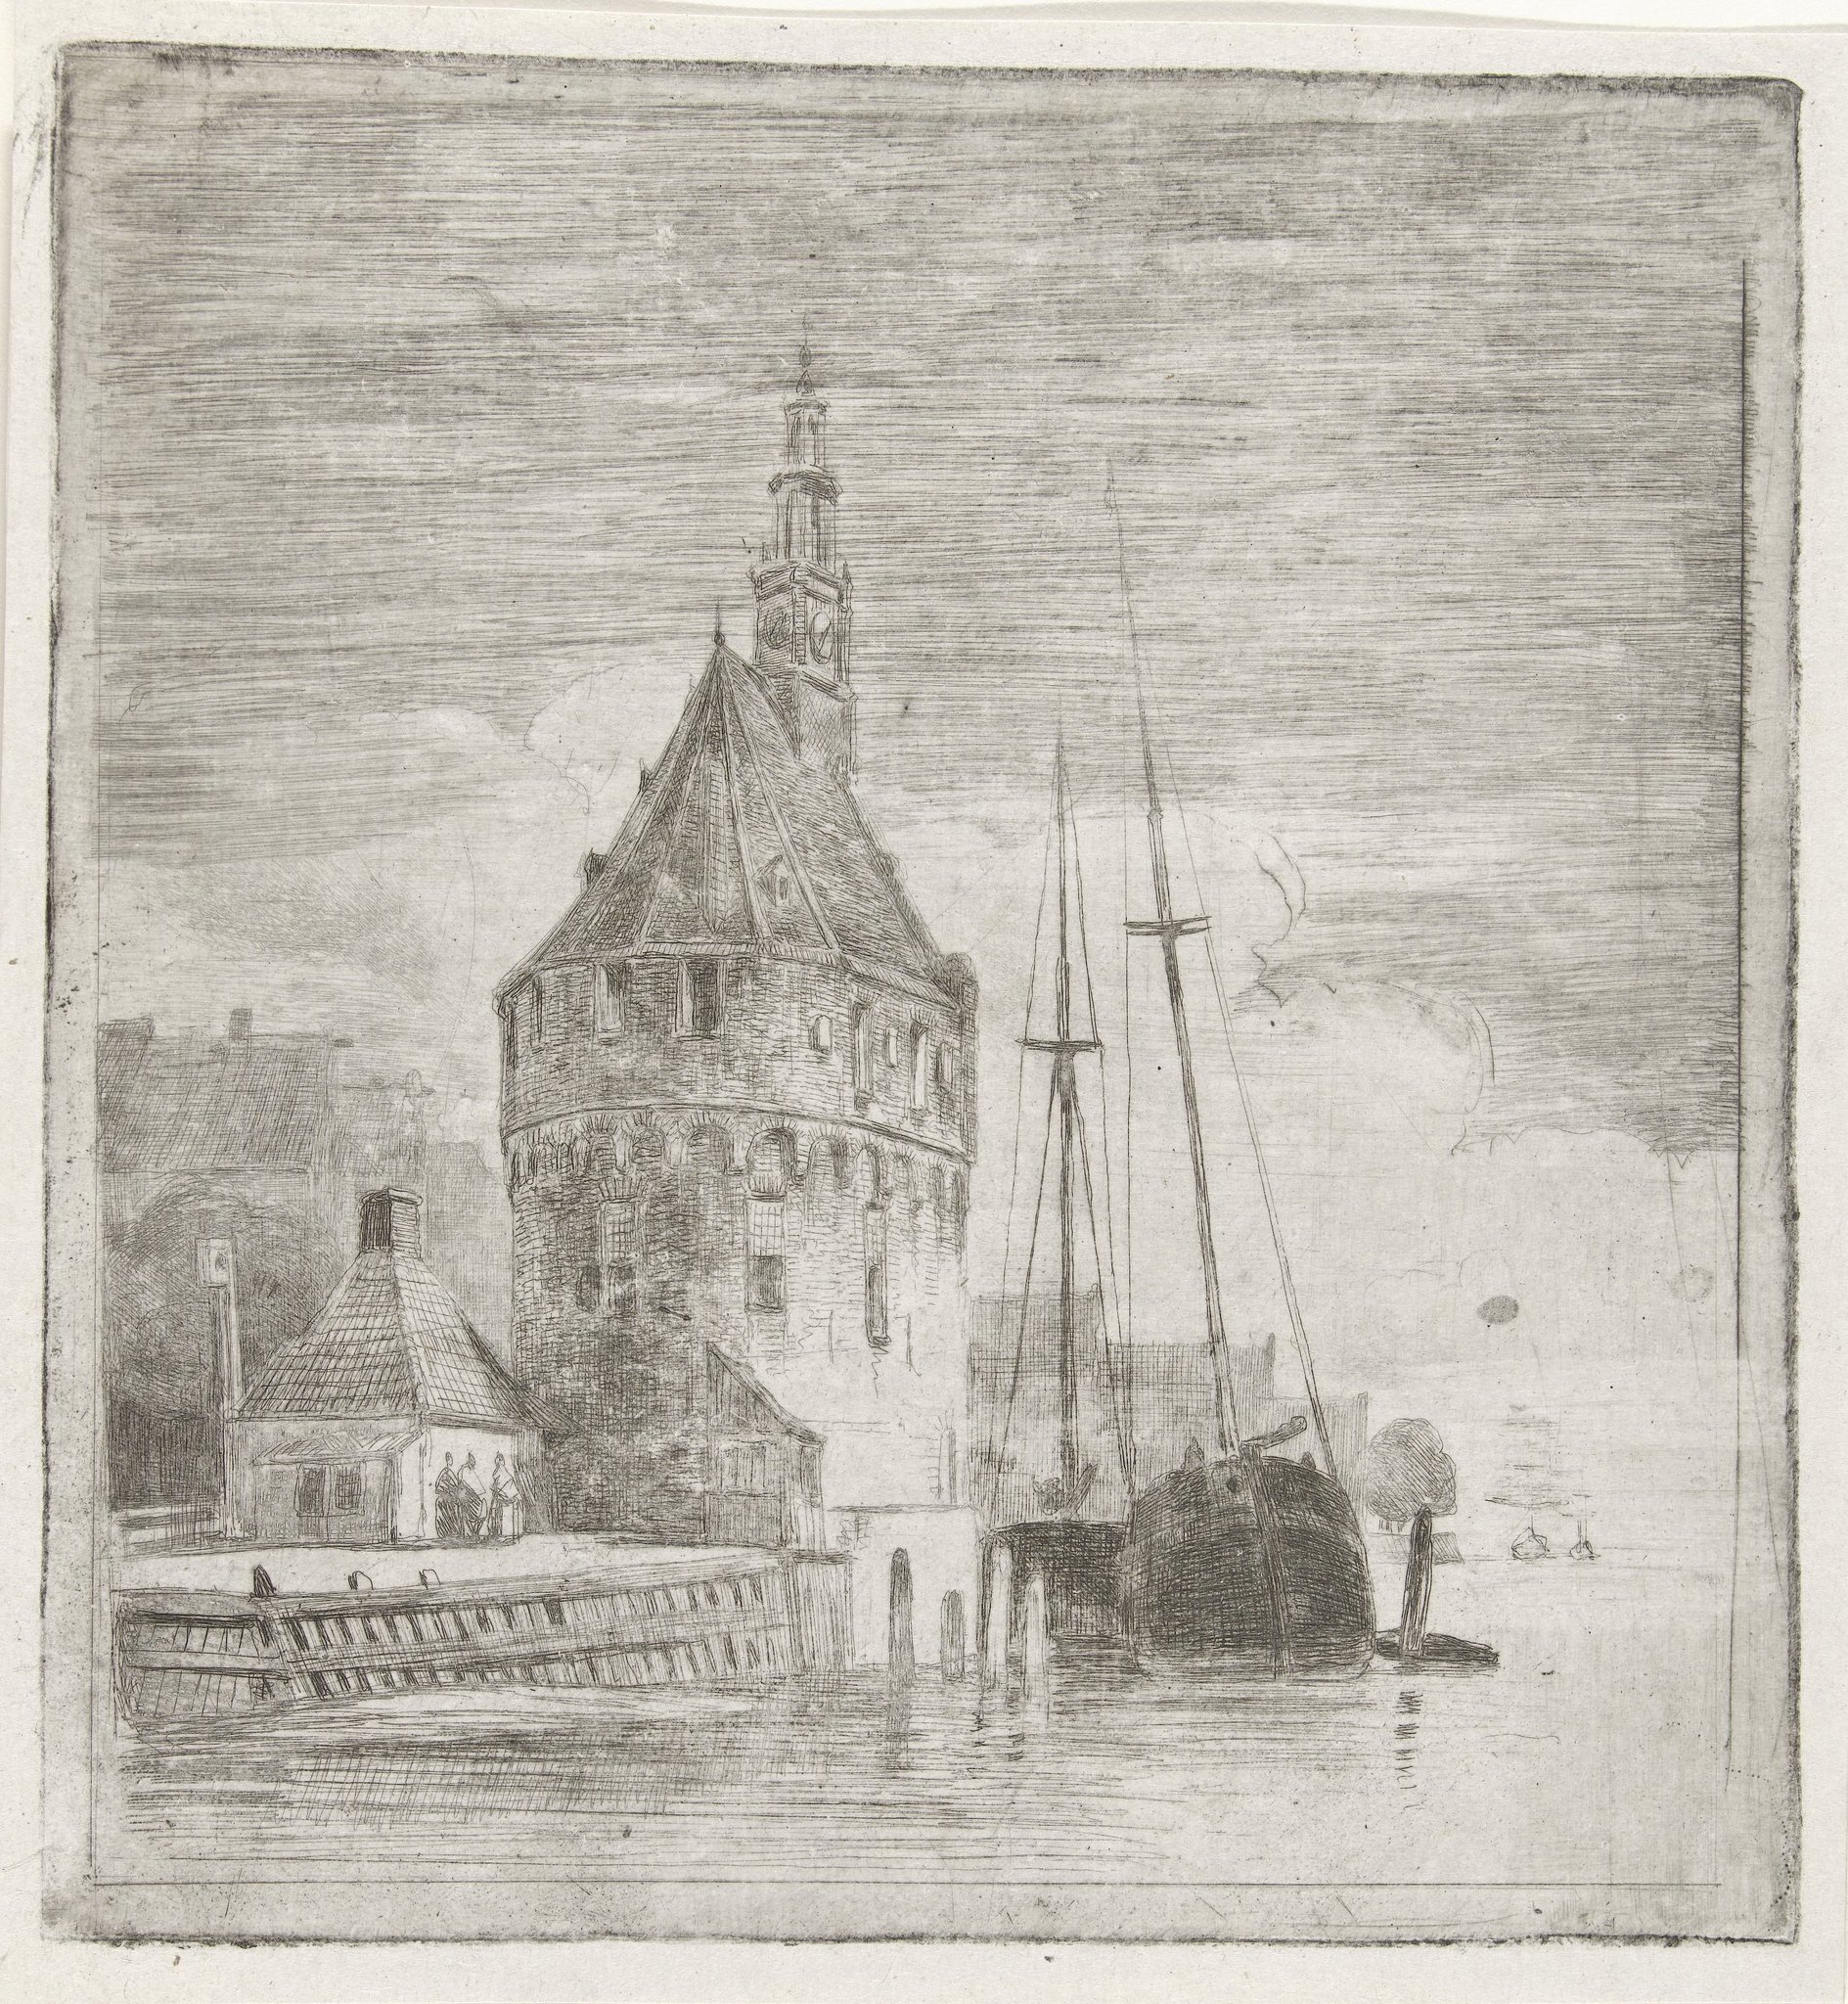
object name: print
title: Toren aan het water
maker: lambertus hardenberg (1822-1900)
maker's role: draughtsman, painter, print maker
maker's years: 1822-1900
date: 1837-1900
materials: paper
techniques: etching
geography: the hague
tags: tower, clock tower ~ monumental adornment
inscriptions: number: ‘No. 42’, collector's mark: Lugt 2228